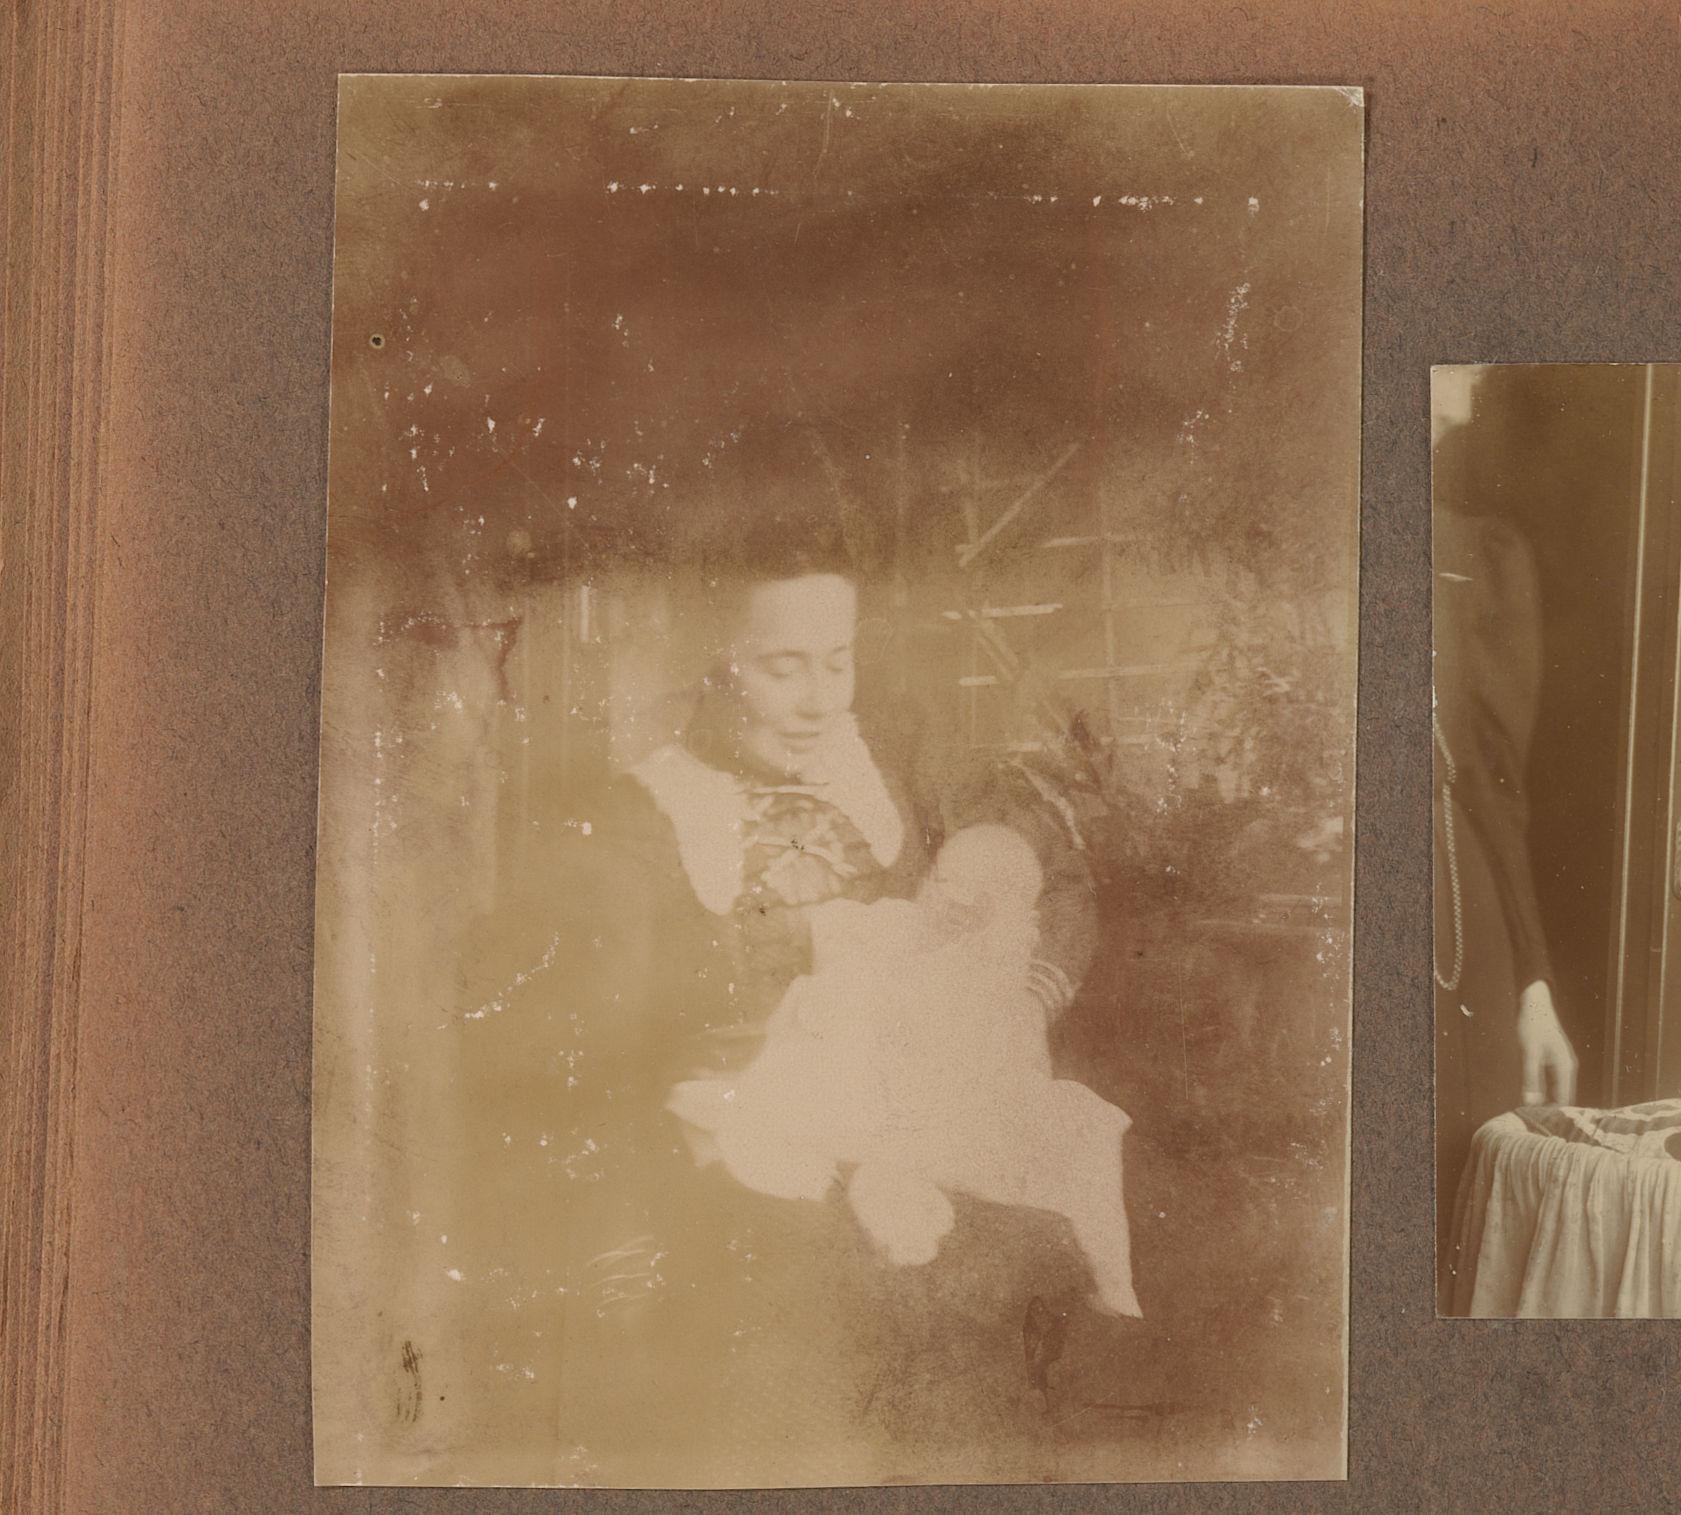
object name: photograph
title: Zittende vrouw met baby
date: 1870-1920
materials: photographic support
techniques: photography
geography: netherlands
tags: netherlands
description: Foto op bruin albumblad 42 van familiealbum van Alphons Diepenbrock.